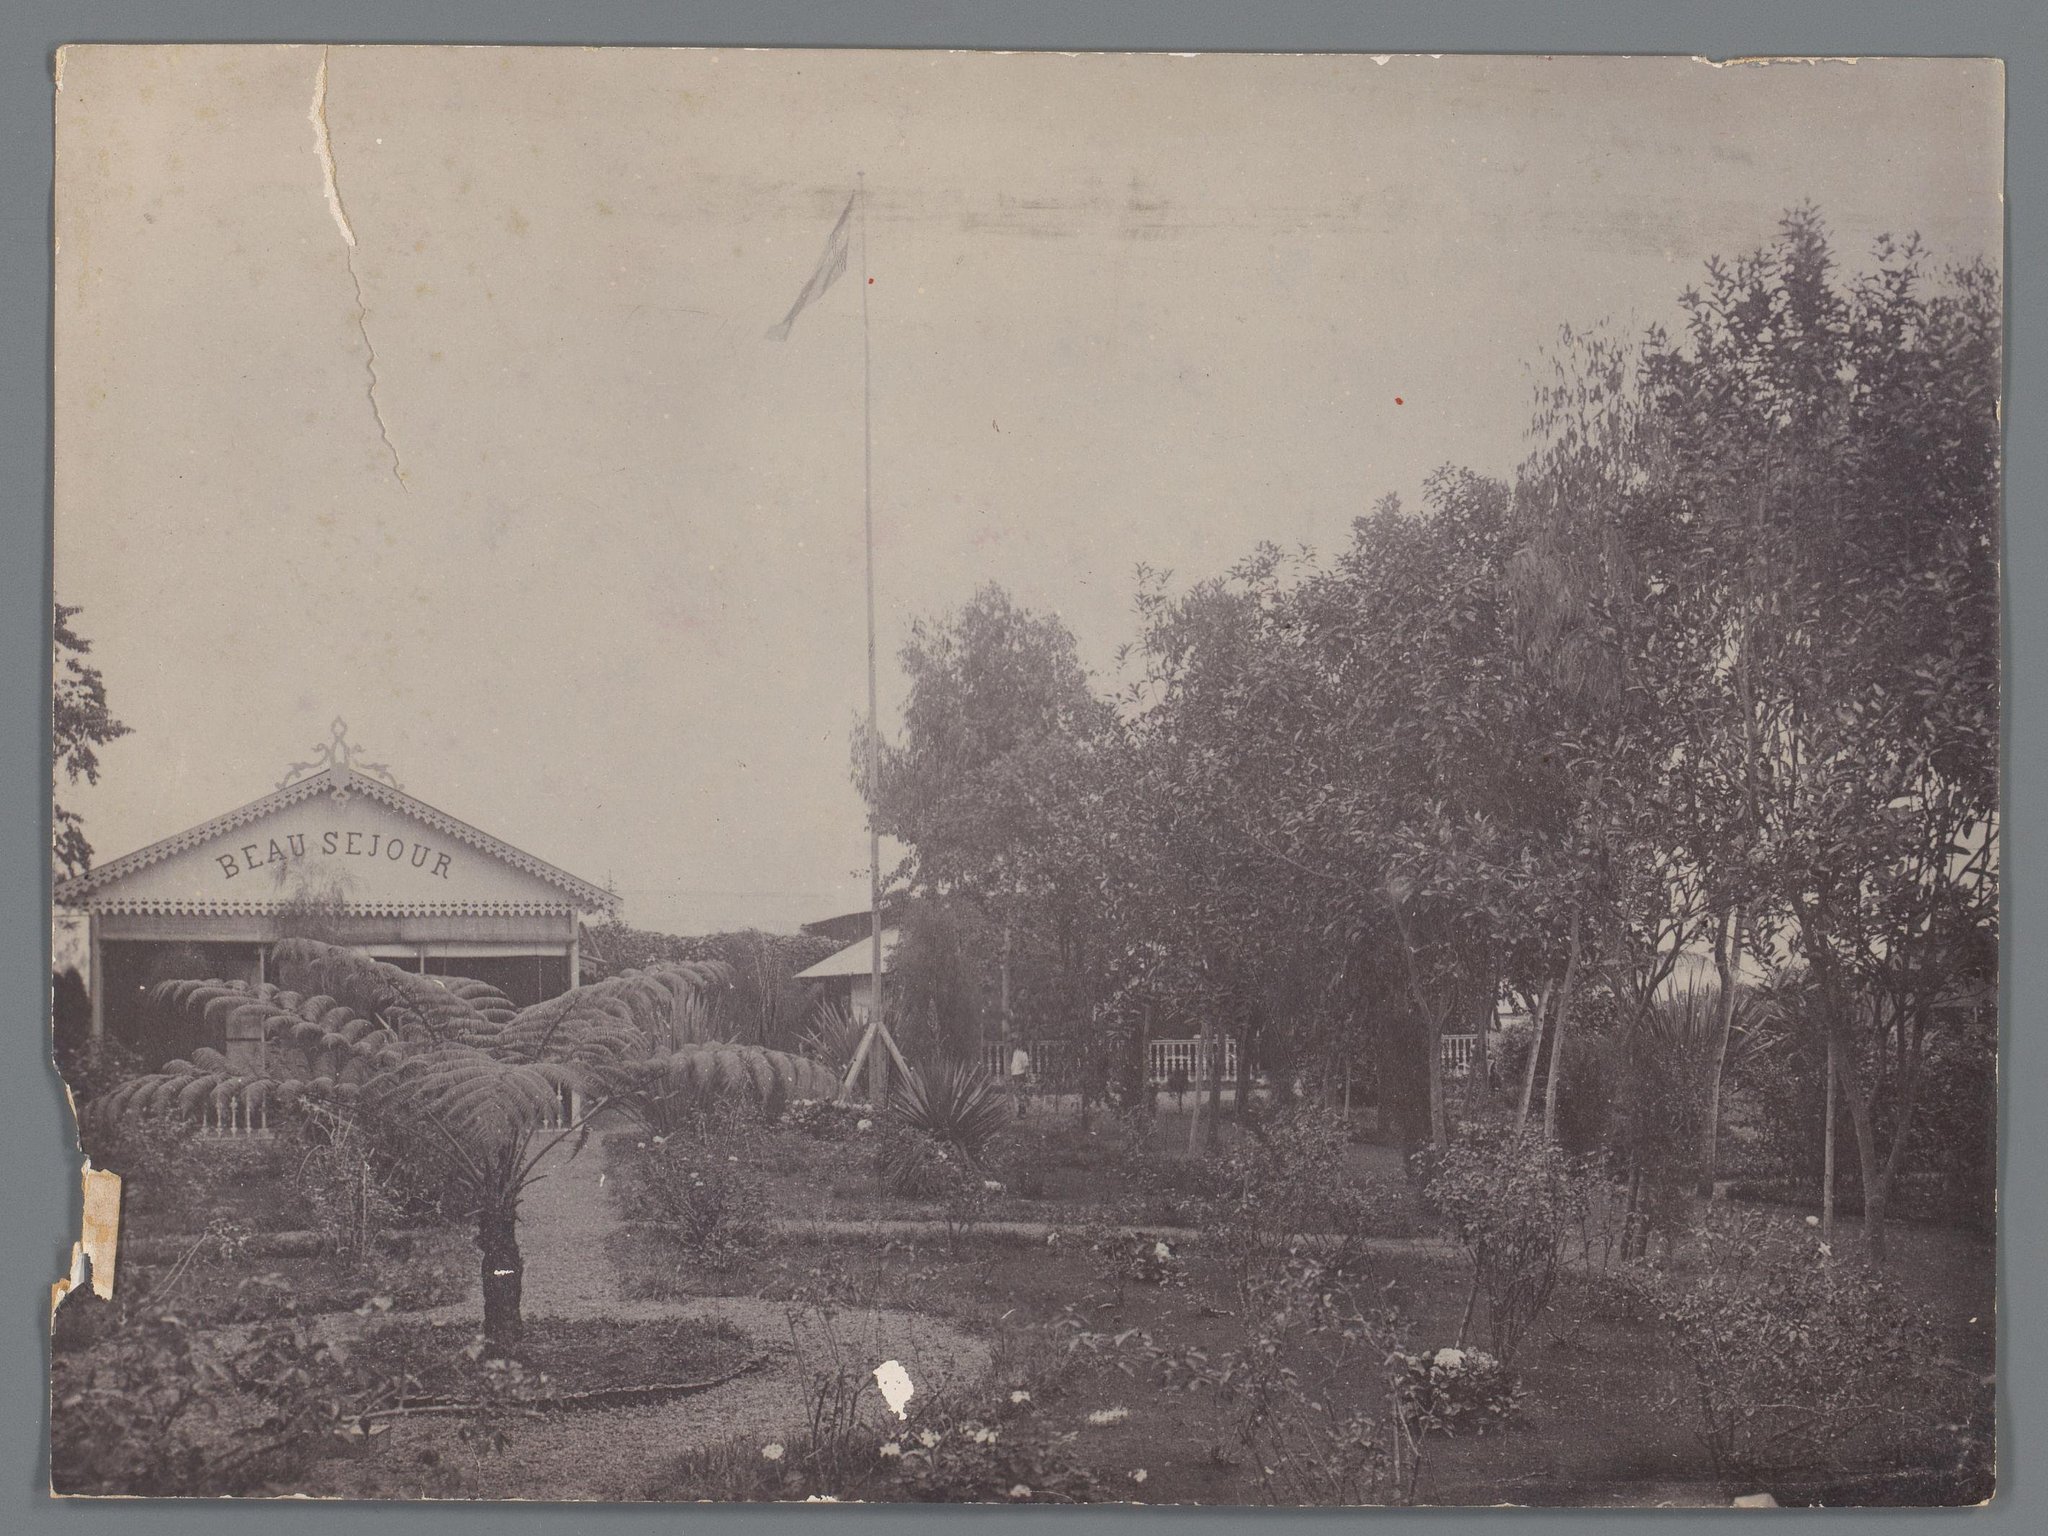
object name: photograph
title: Tuin van het huis Beau Séjour, Nederlands-Indië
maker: Anonymous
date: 1890-1910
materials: paper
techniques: matte daylight collodion silver print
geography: dutch east indies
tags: garden, rural housing, e.g. country-house, villa, cottage, dutch east indies, the